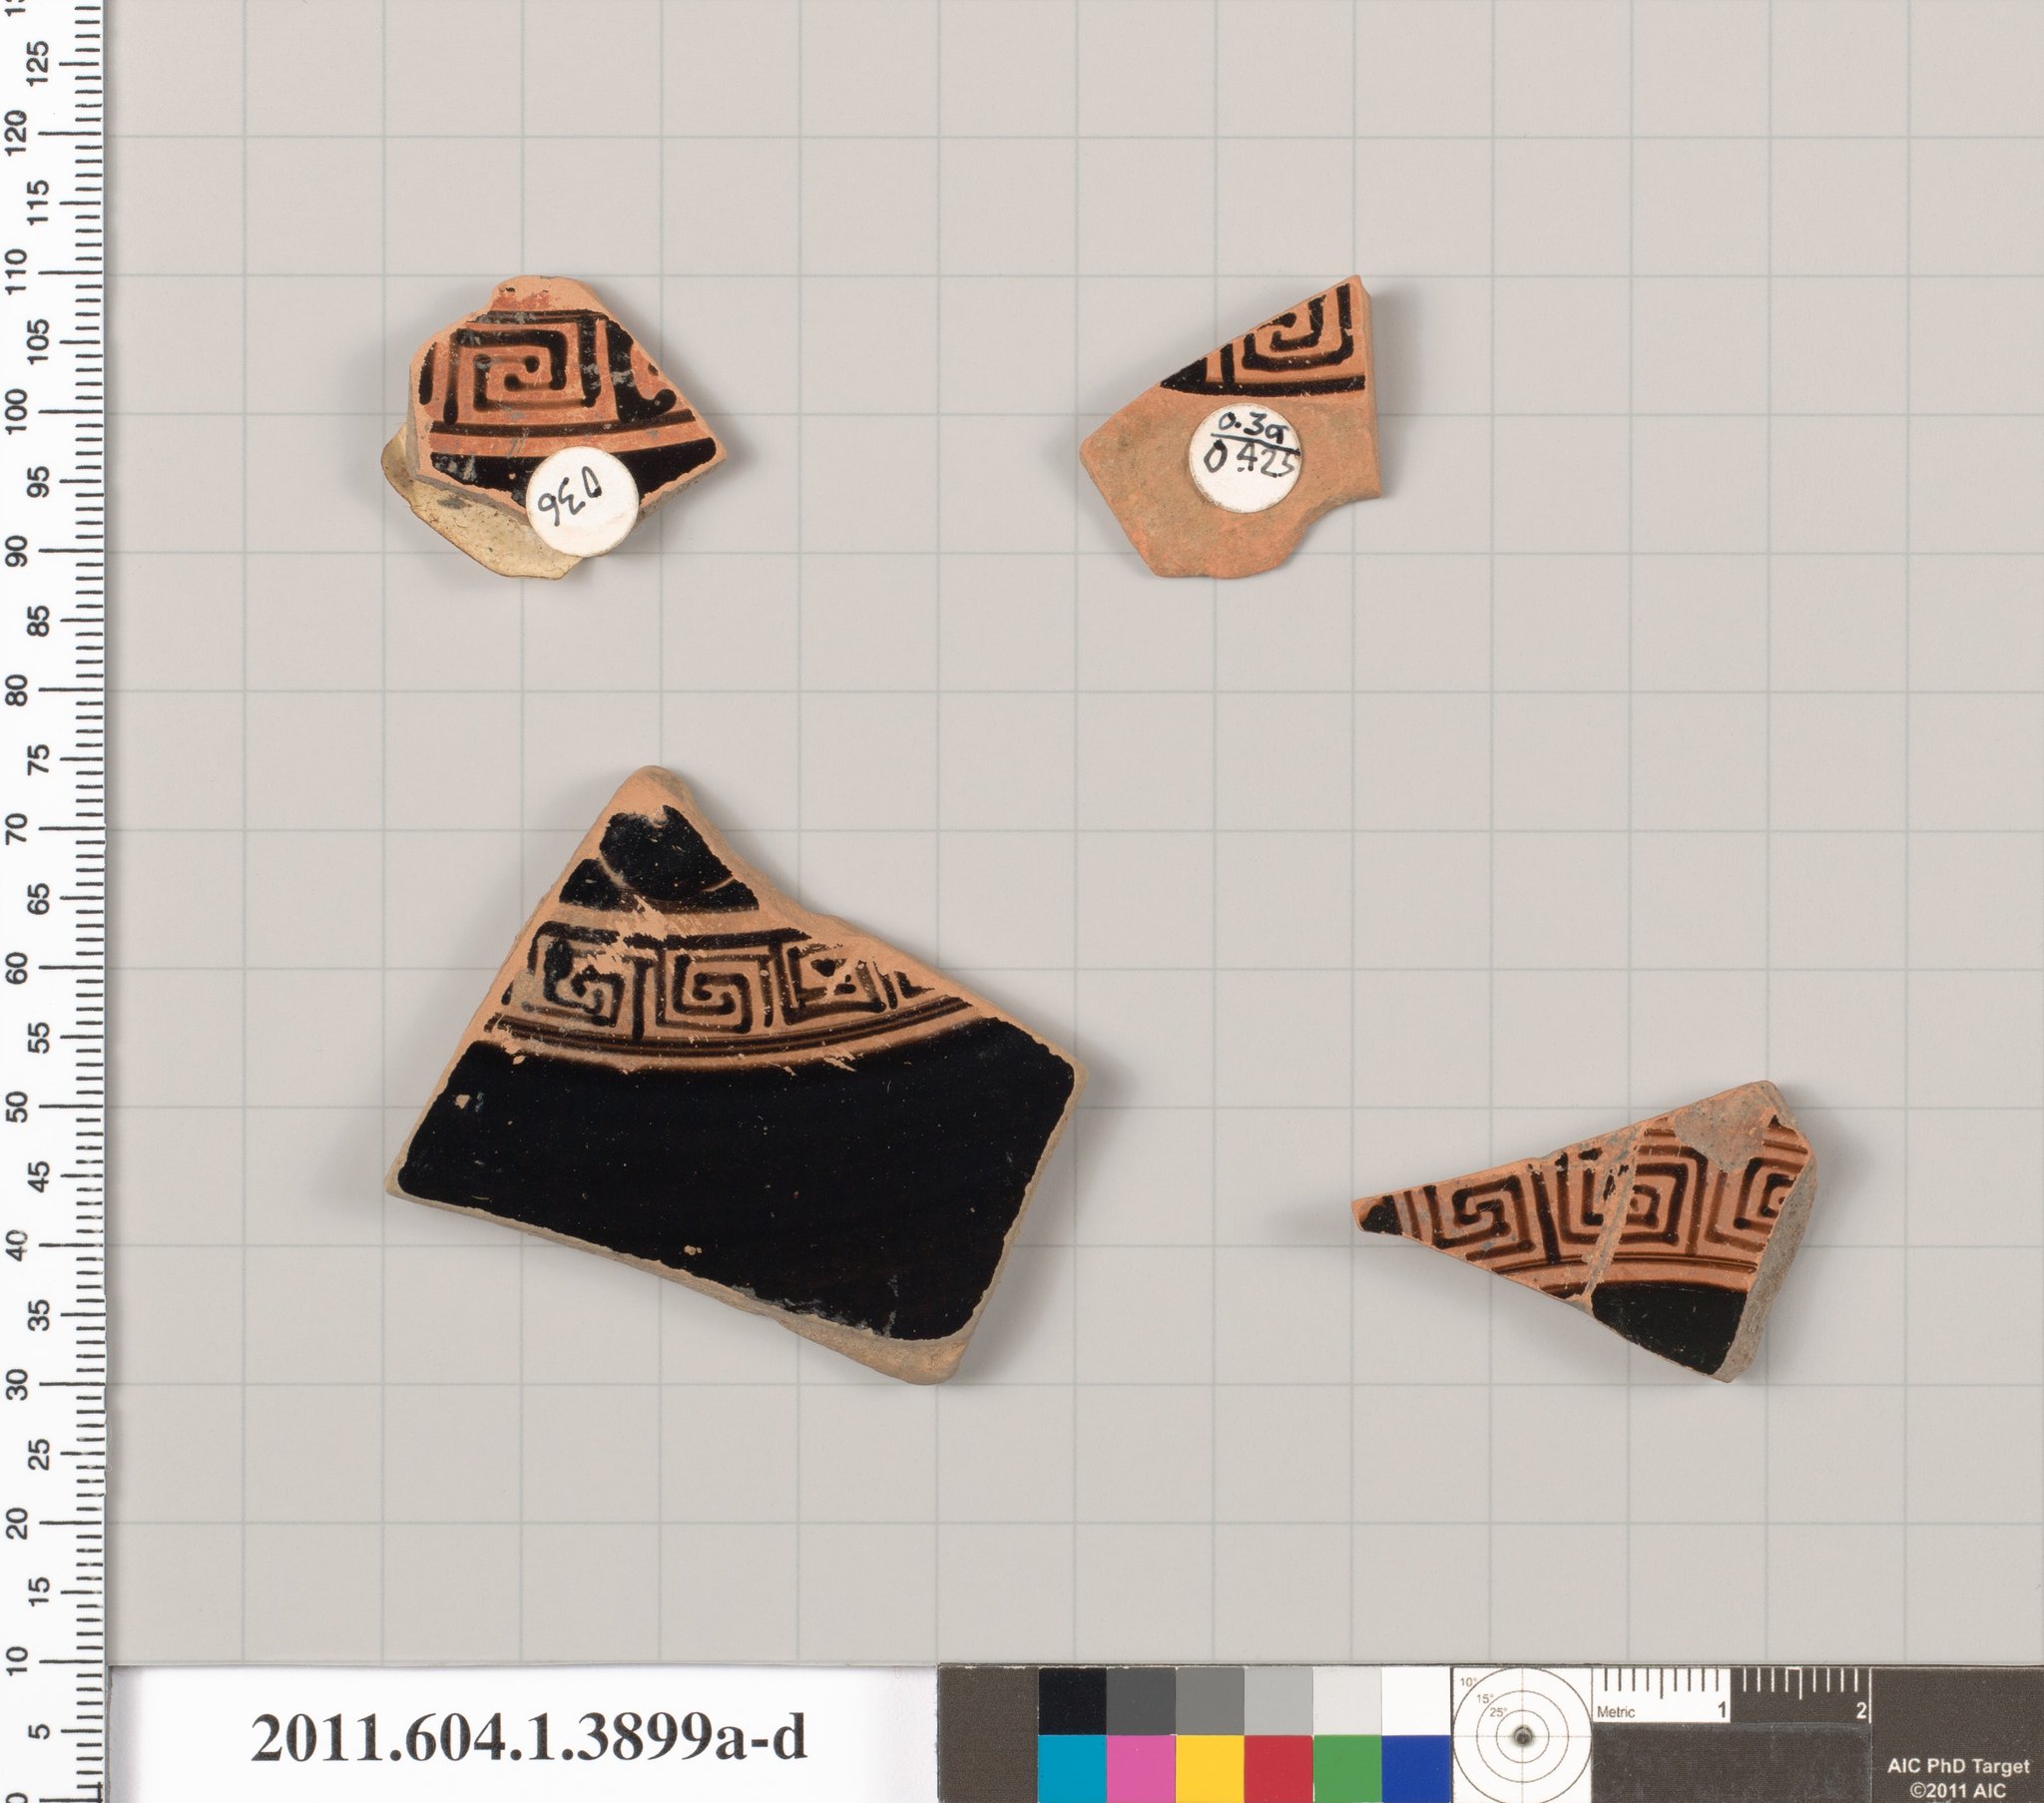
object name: kylix fragment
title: Terracotta fragments of kylikes (drinking cups)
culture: greek, attic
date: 475-451 BCE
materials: terracotta